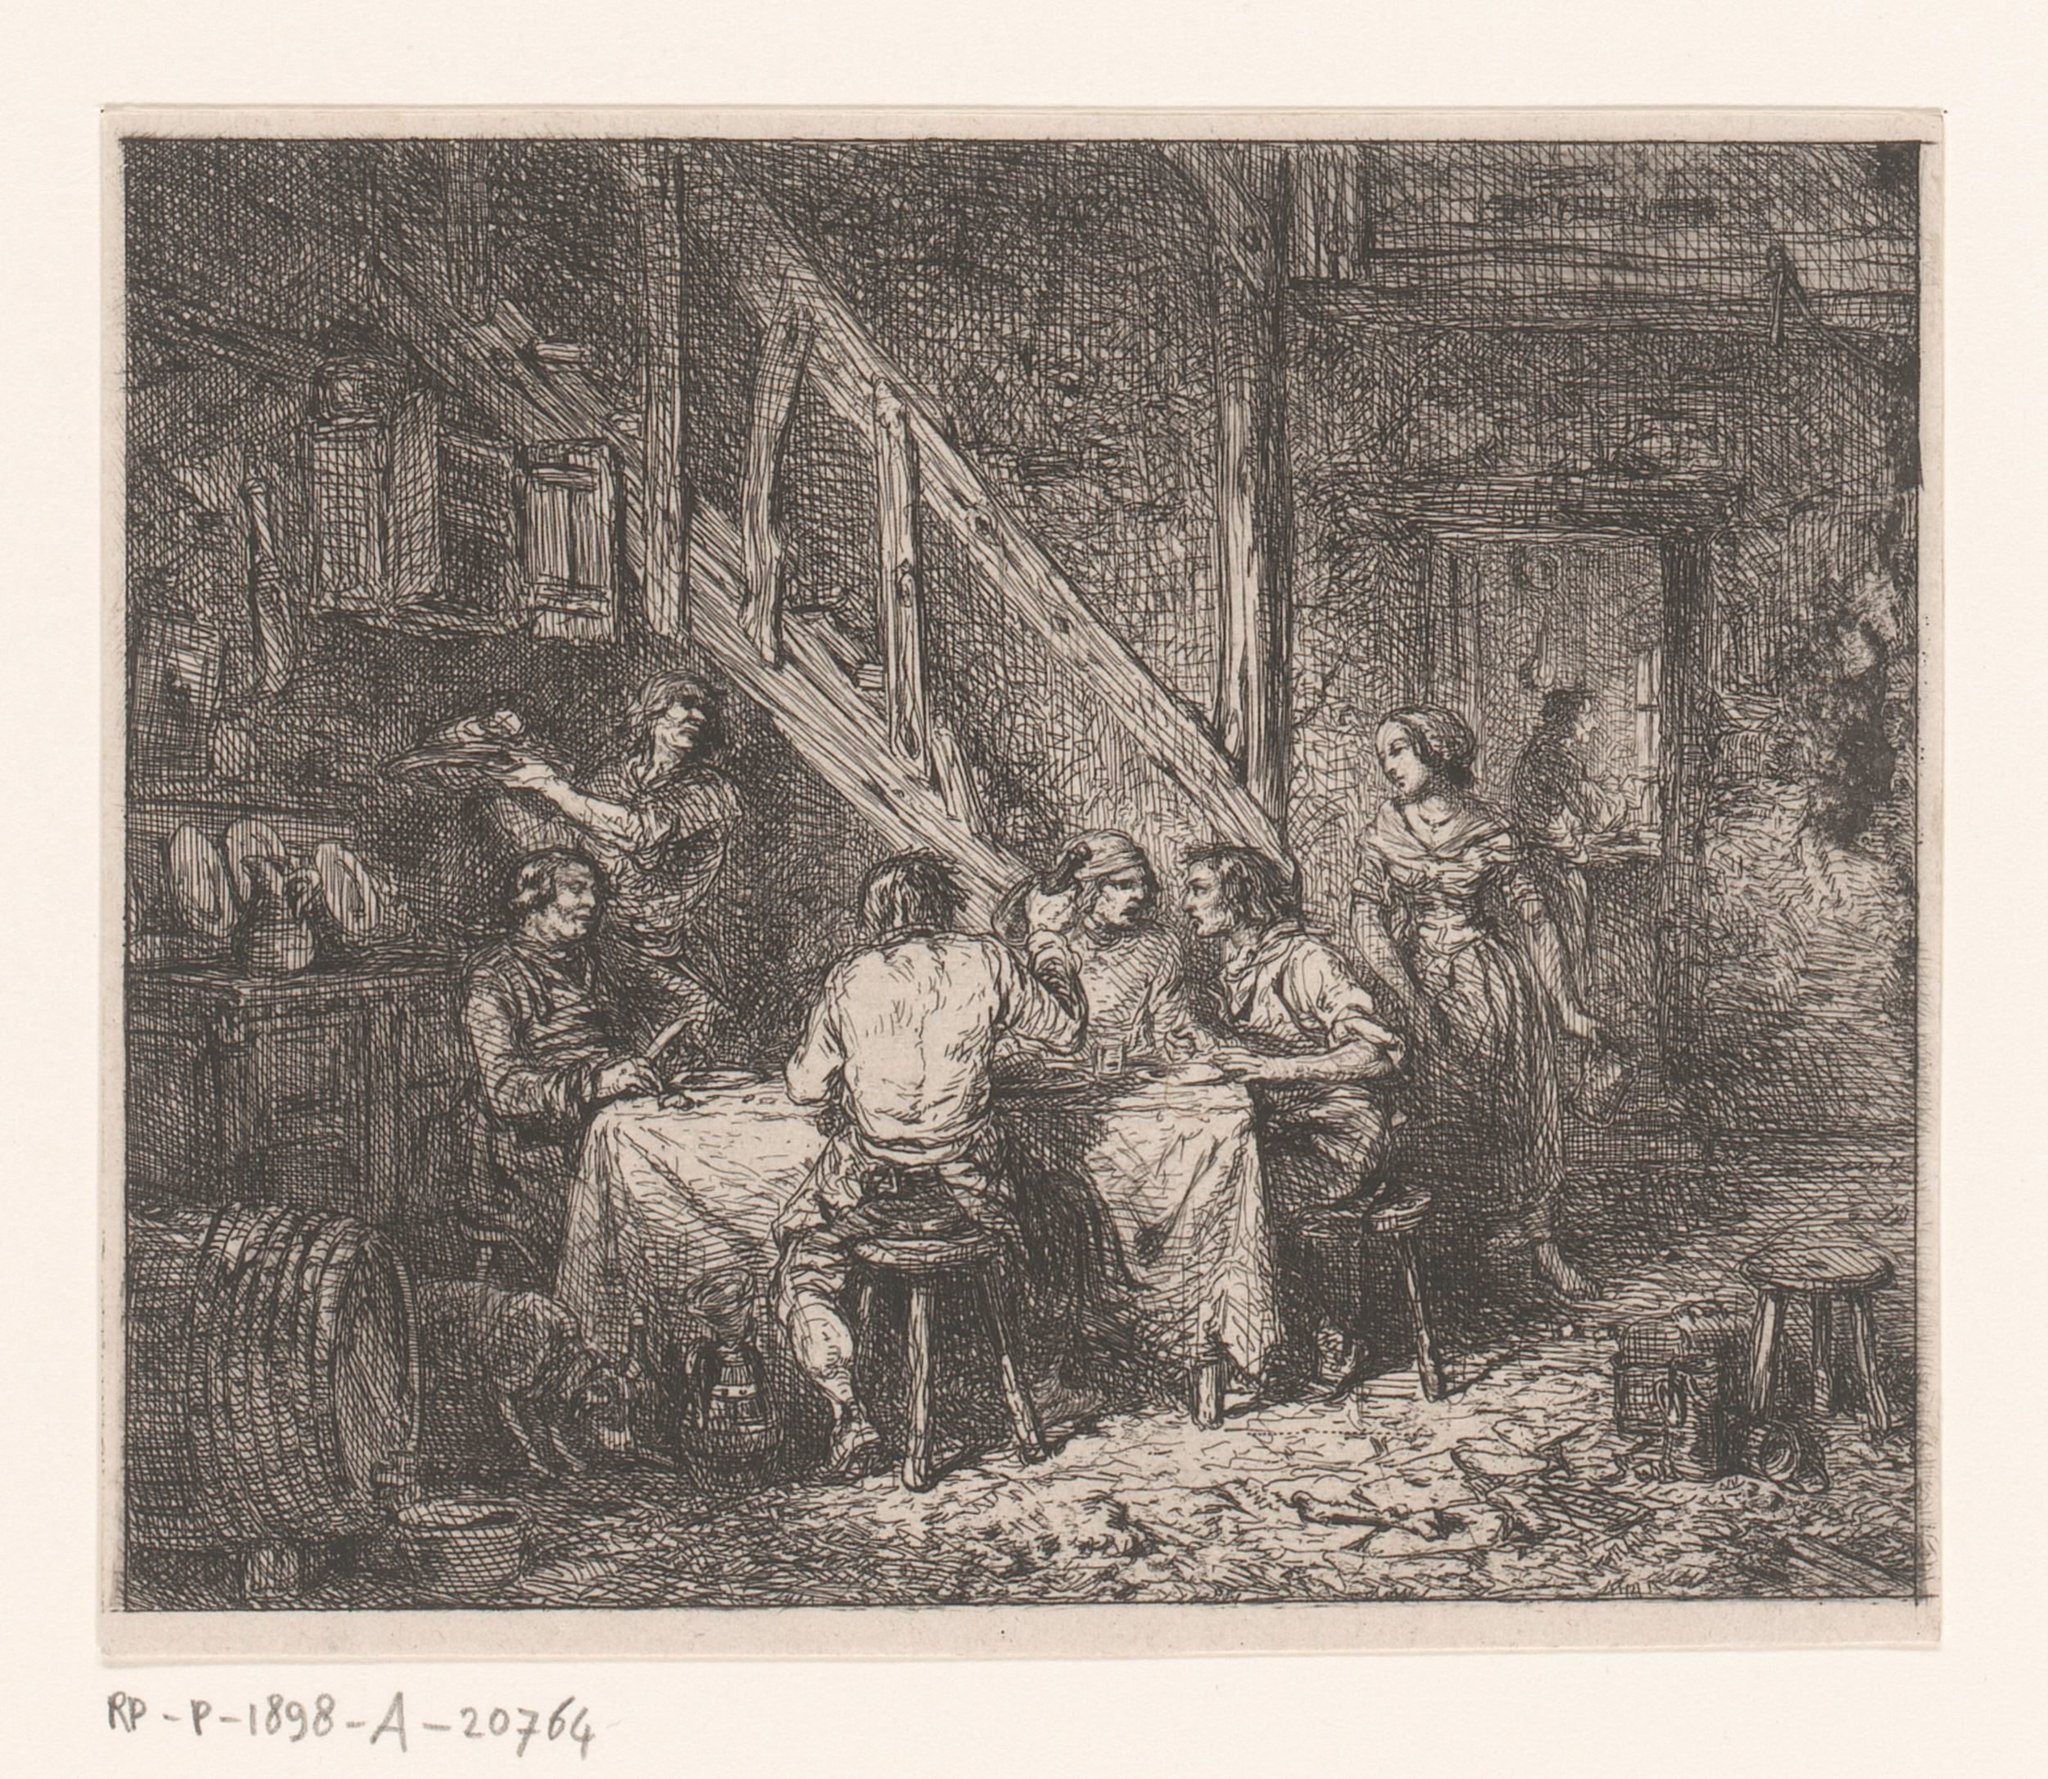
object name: print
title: Figuren aan een maaltijd in een boereninterieur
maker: charles emile jacque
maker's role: draughtsman, painter, print maker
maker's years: 1813-1894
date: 1823-1894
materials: paper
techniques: etching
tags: farmers, eating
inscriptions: collector's mark: Lugt 964